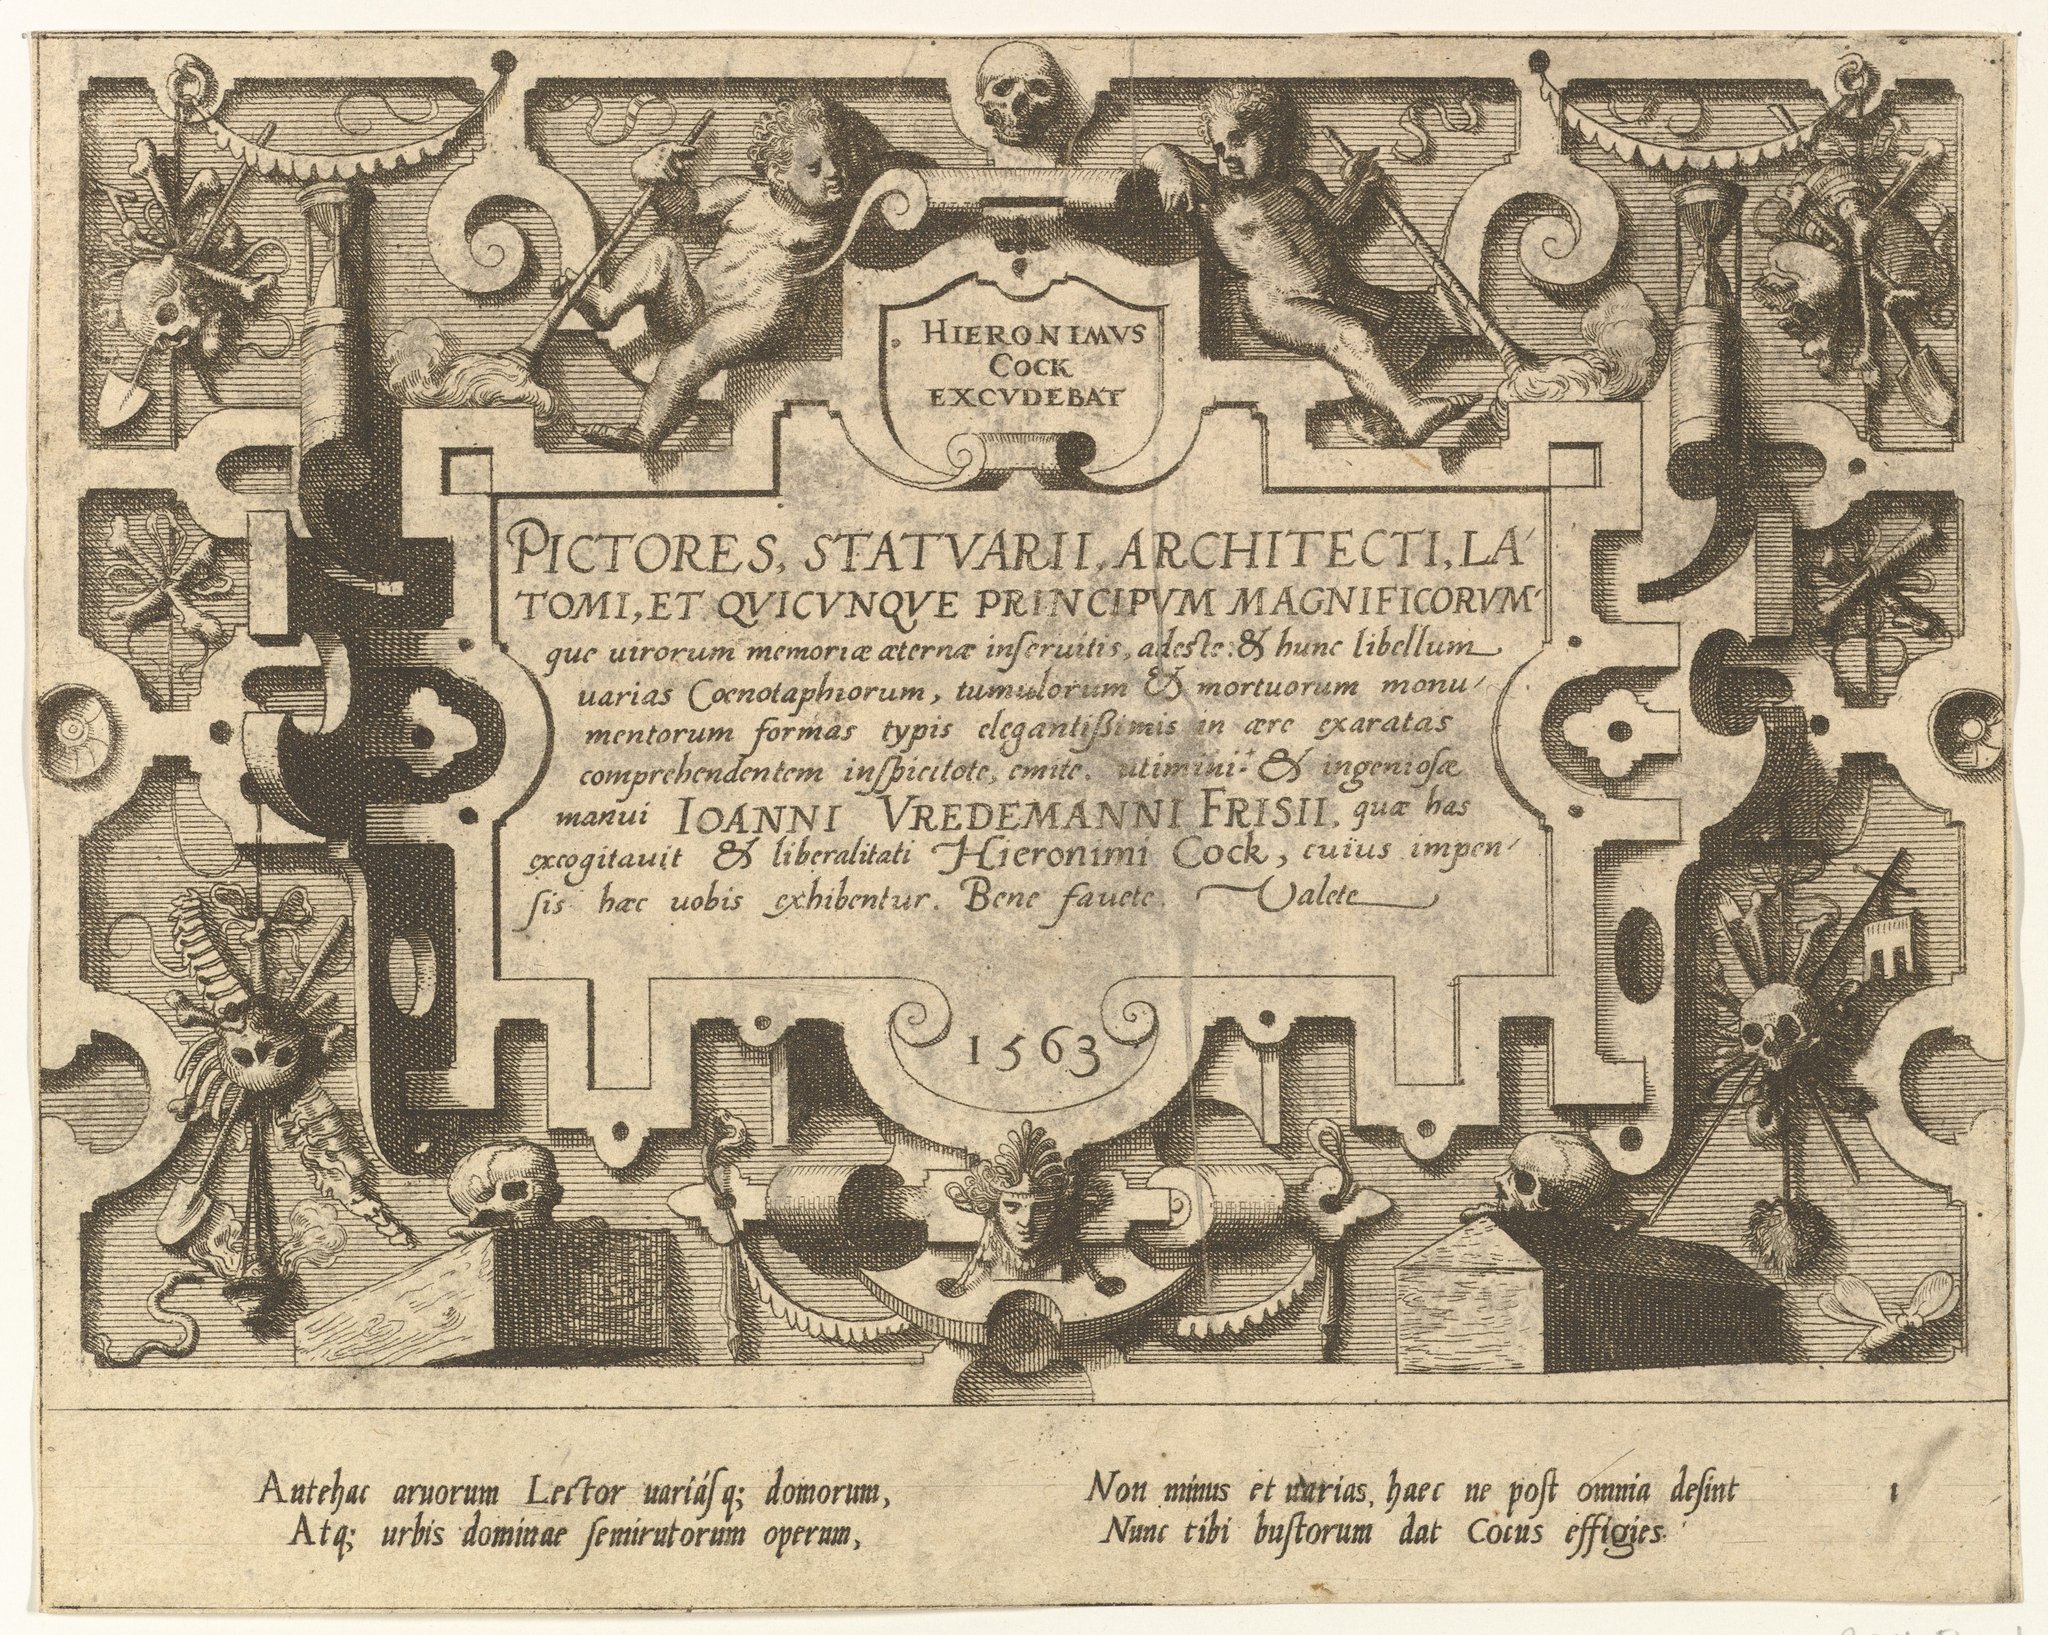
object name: collection ornament architecture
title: Cœnotaphiorum (title page)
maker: hans vredeman de vries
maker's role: artist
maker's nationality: netherlandish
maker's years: 1527-1606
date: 1563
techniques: etching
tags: skulls,putti